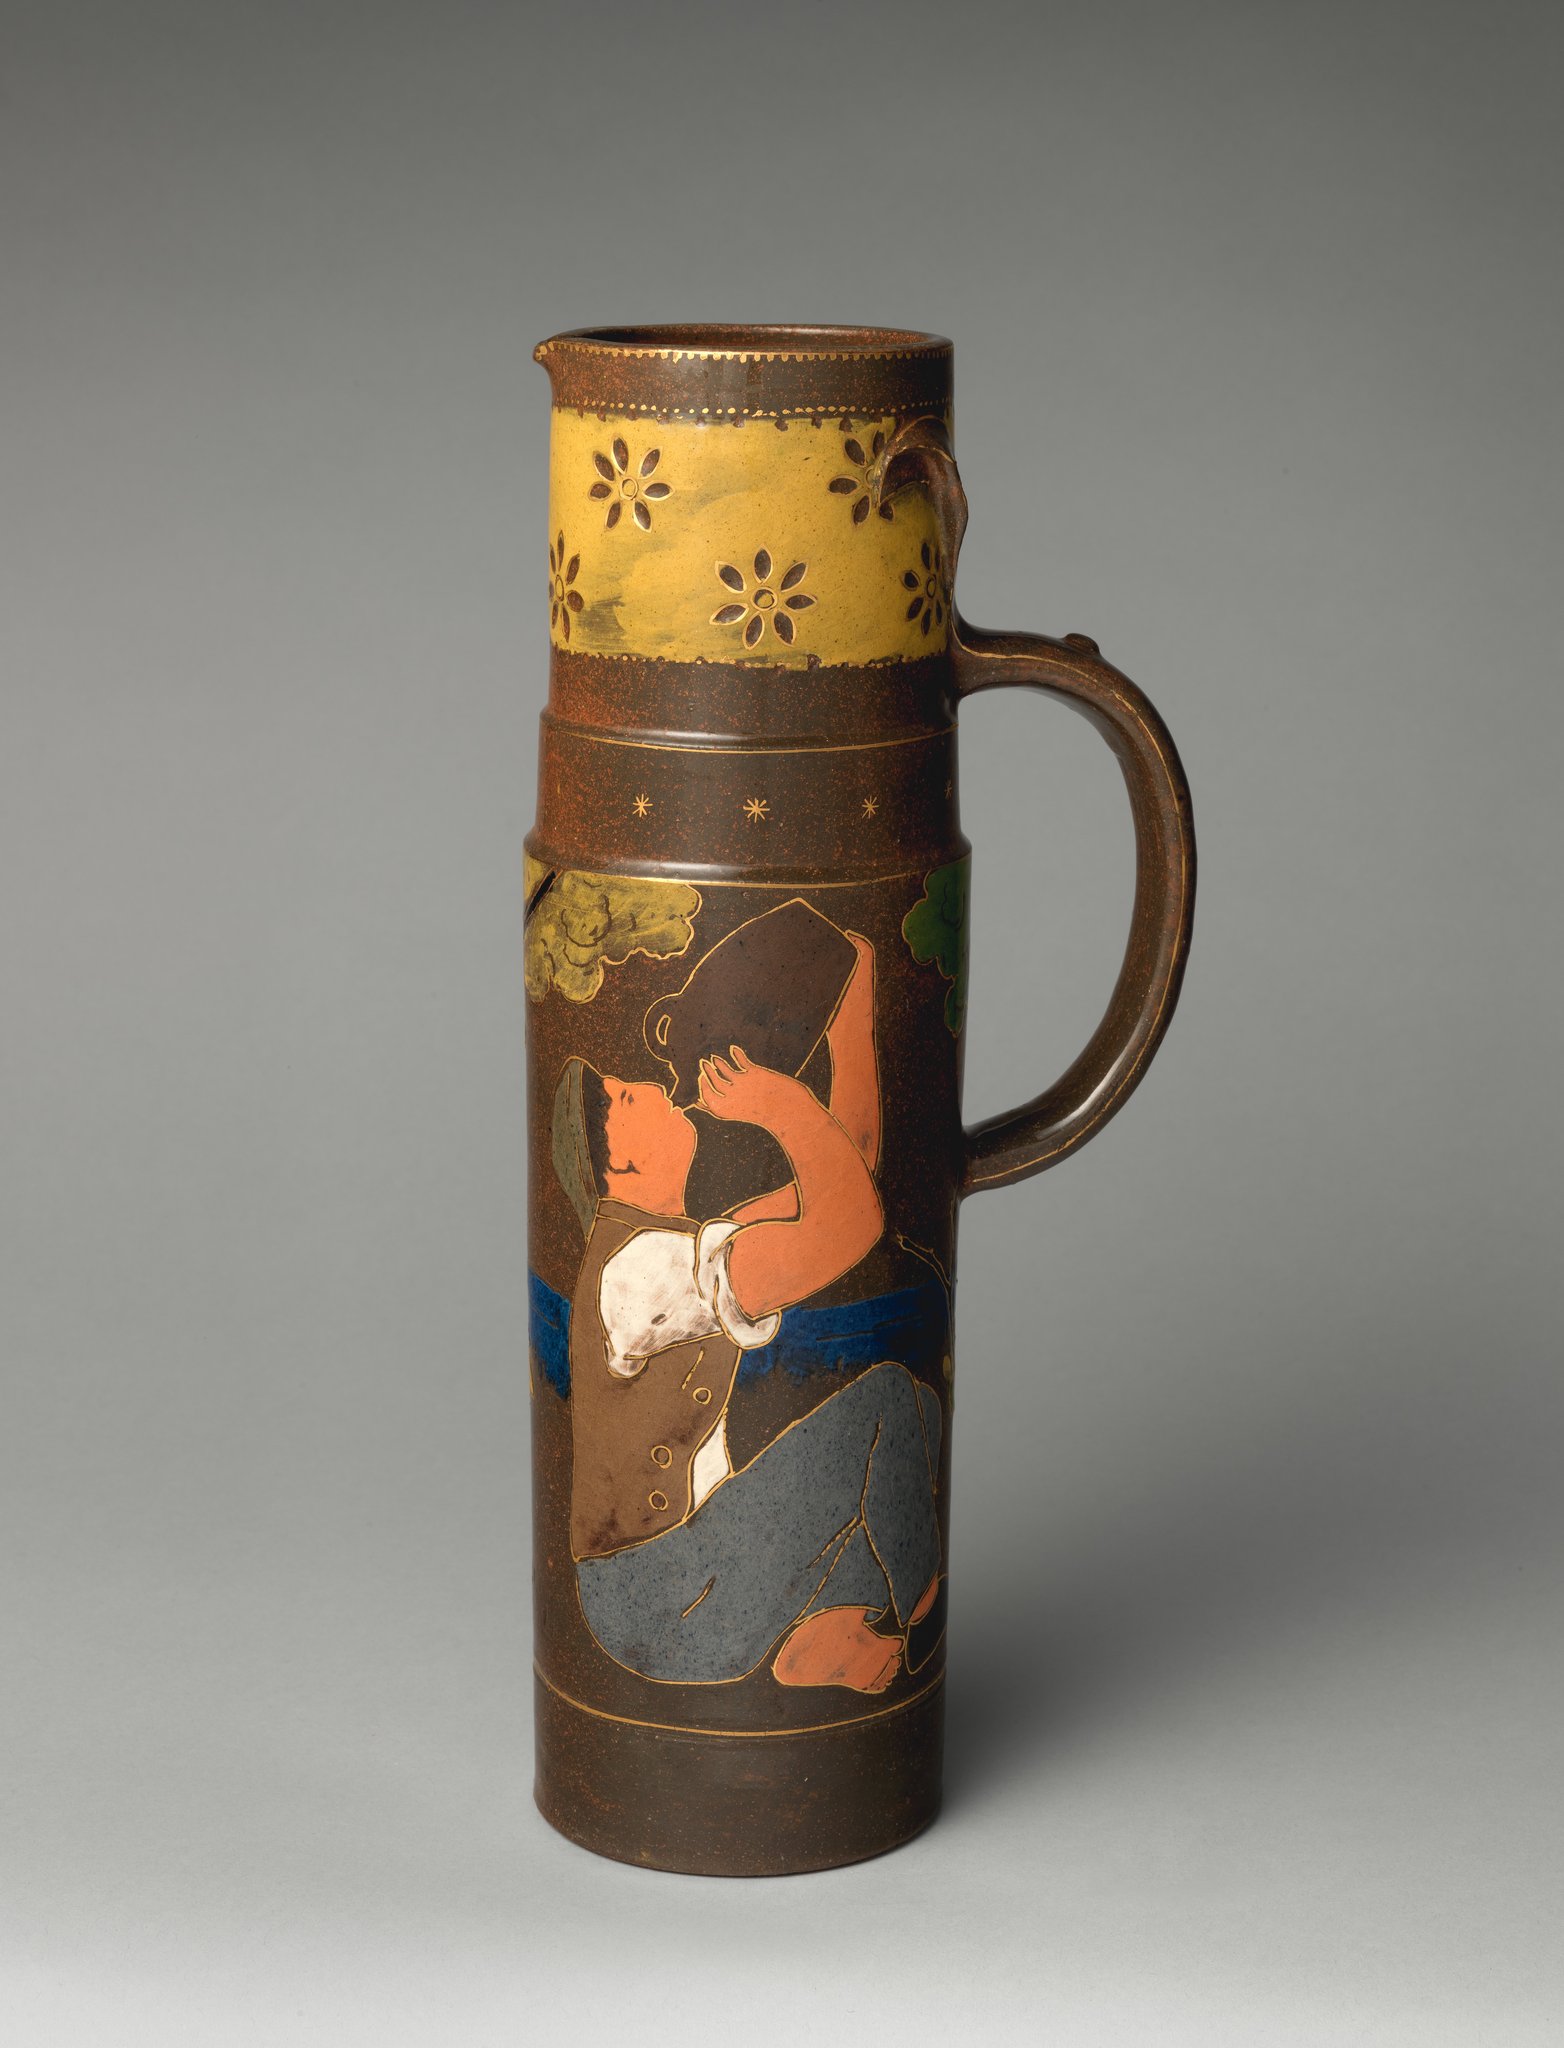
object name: tankard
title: Tankard with man drinking from jug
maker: haviland & co.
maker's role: manufactory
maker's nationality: american and french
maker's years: 1864-1931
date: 1885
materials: stoneware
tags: men,trees,drinking